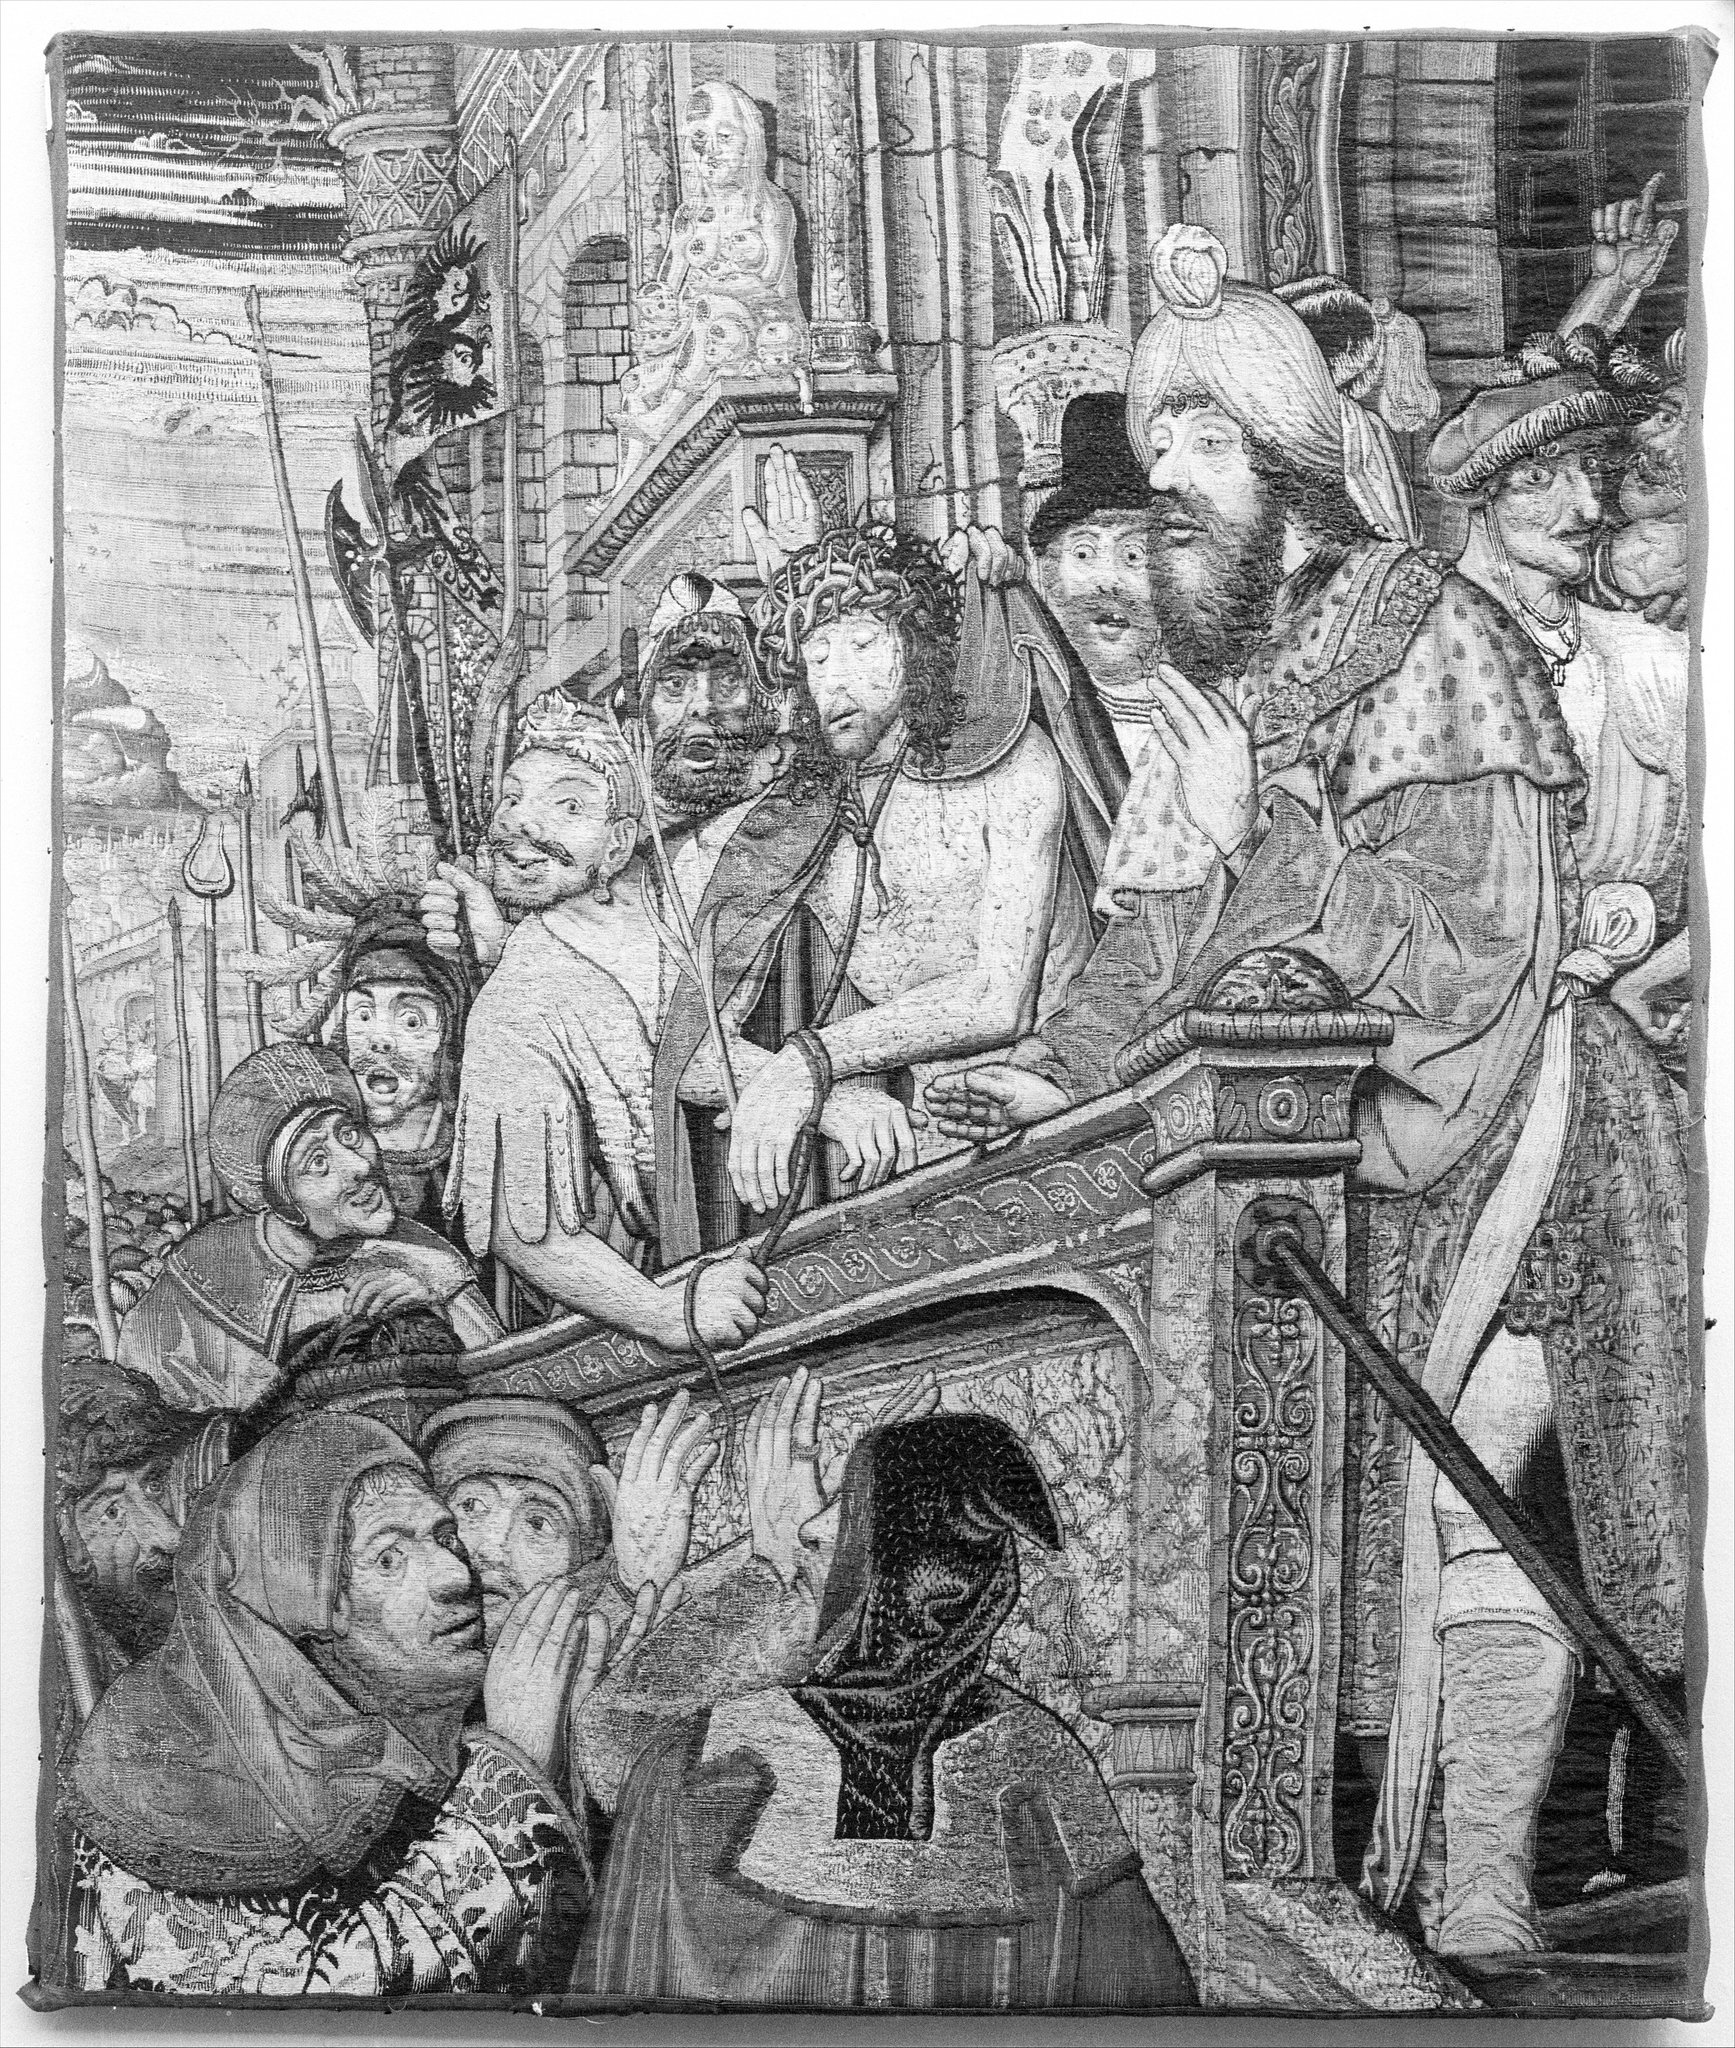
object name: tapestry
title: Christ Shown to the People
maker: quentin metsys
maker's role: designer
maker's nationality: netherlandish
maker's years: 1466-1530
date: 1515-1520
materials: silk, silver, silver gilt, thread, wool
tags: men,christ